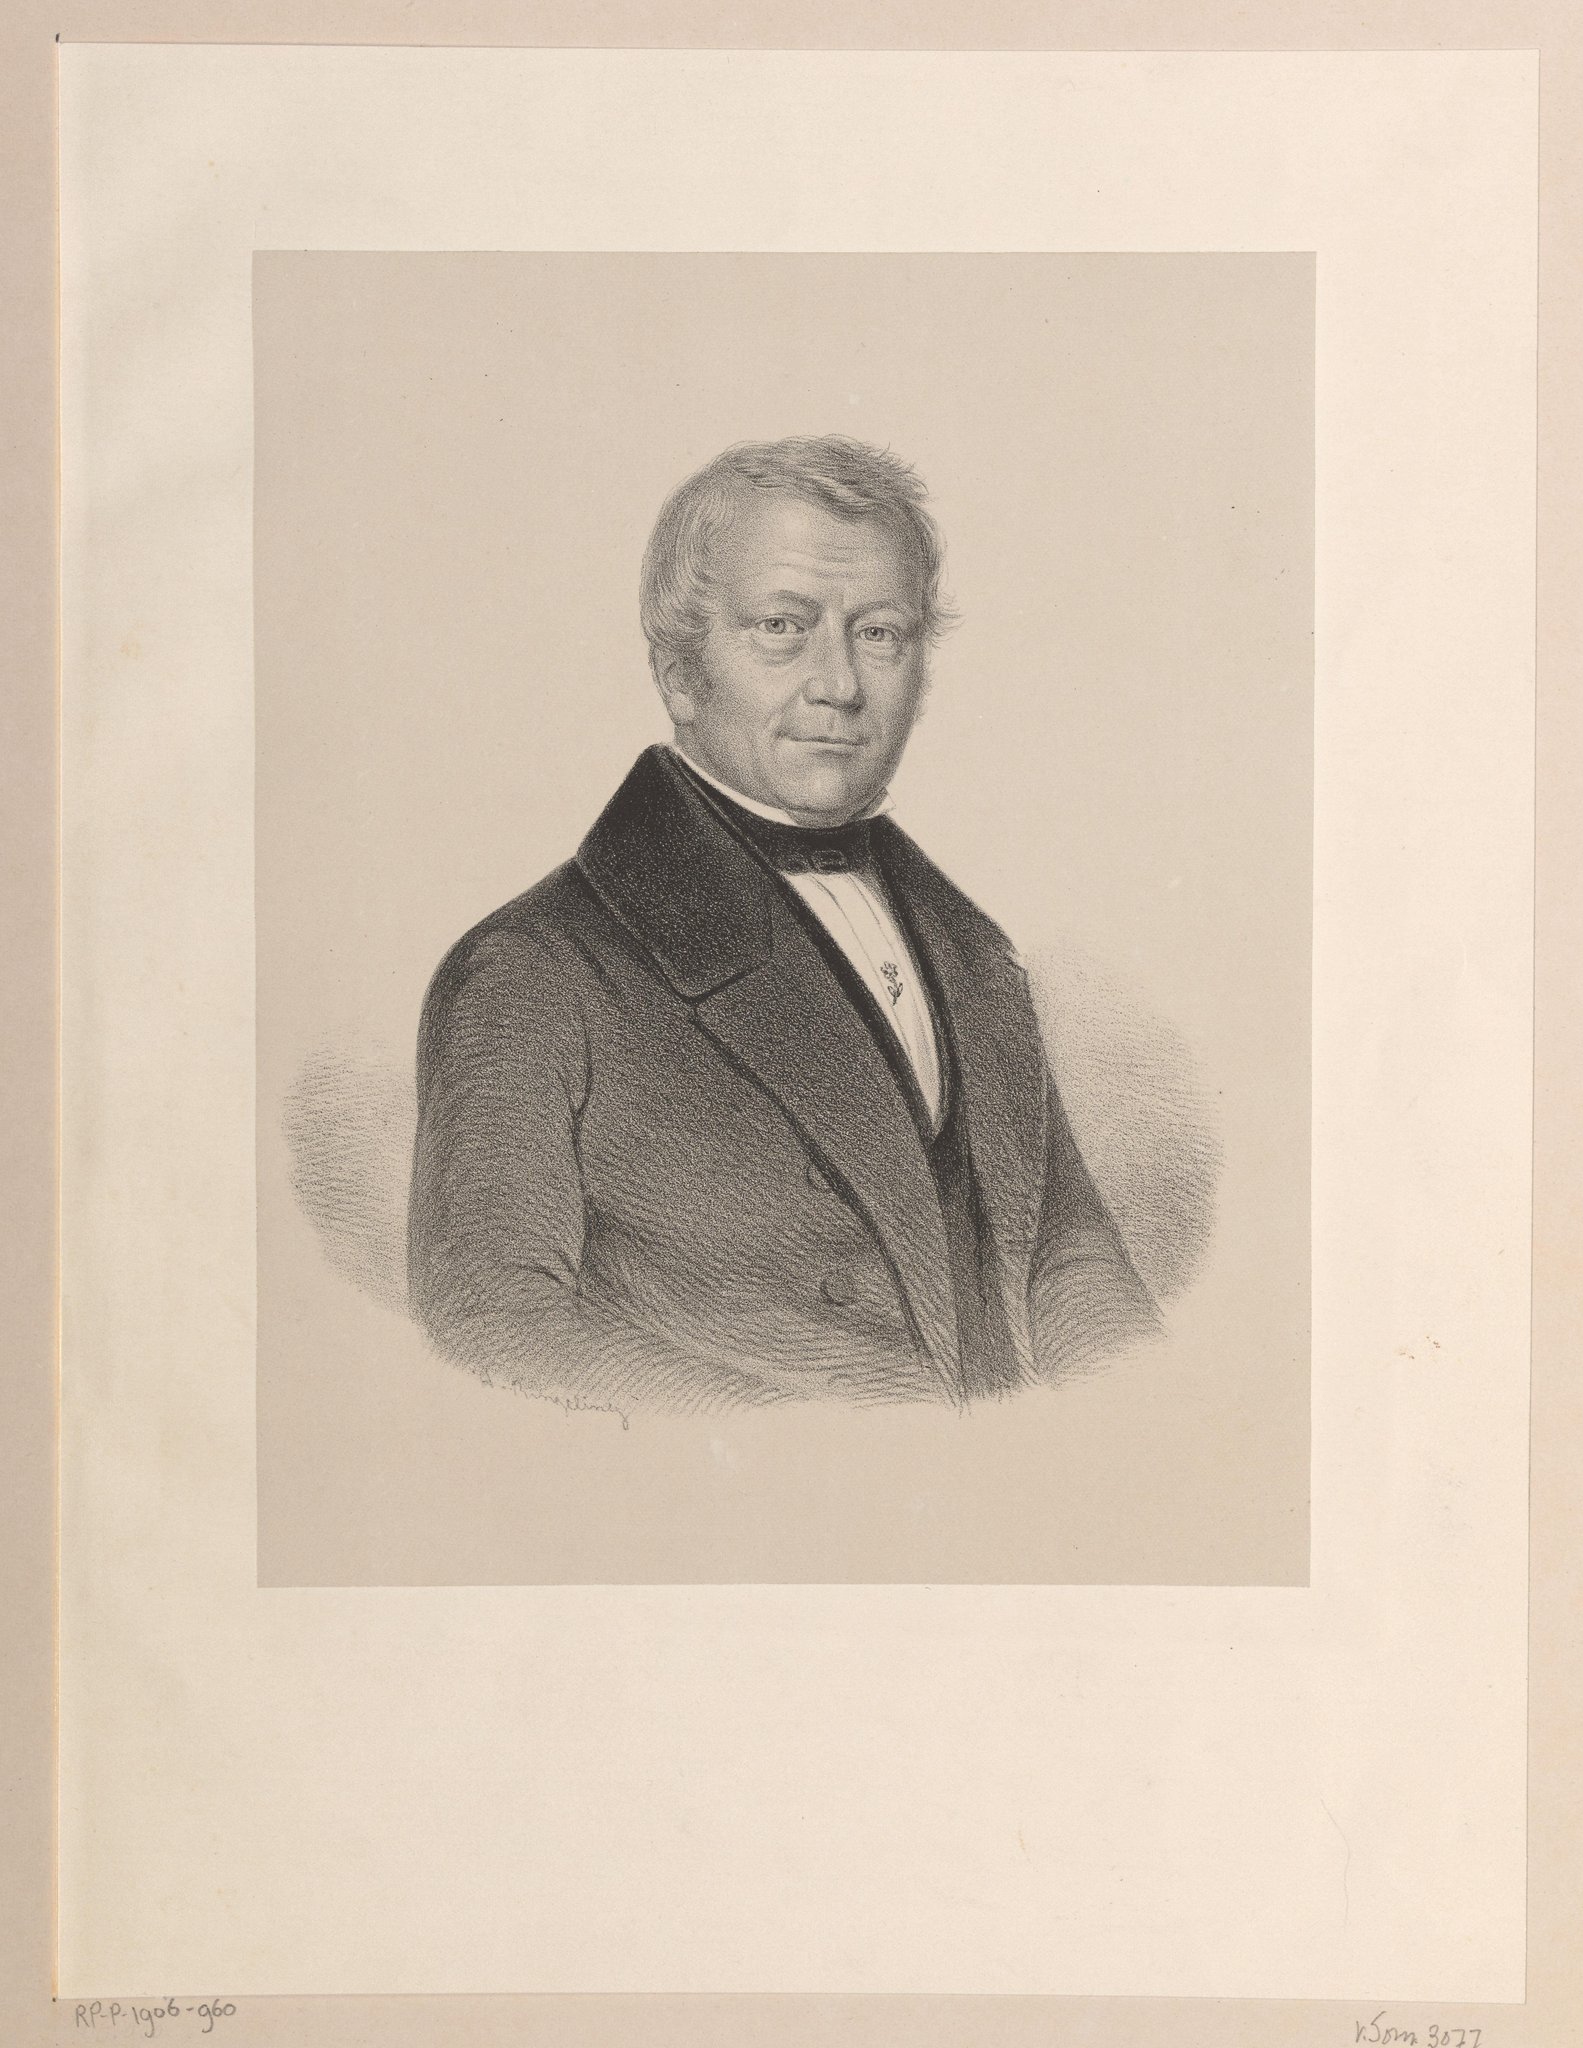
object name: print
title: Portret van J. Kros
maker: hendrik ringeling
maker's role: print maker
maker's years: 1812-1874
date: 1864-1874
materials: paper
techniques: lithograph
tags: historical persons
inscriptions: collector's mark: Lugt 2228